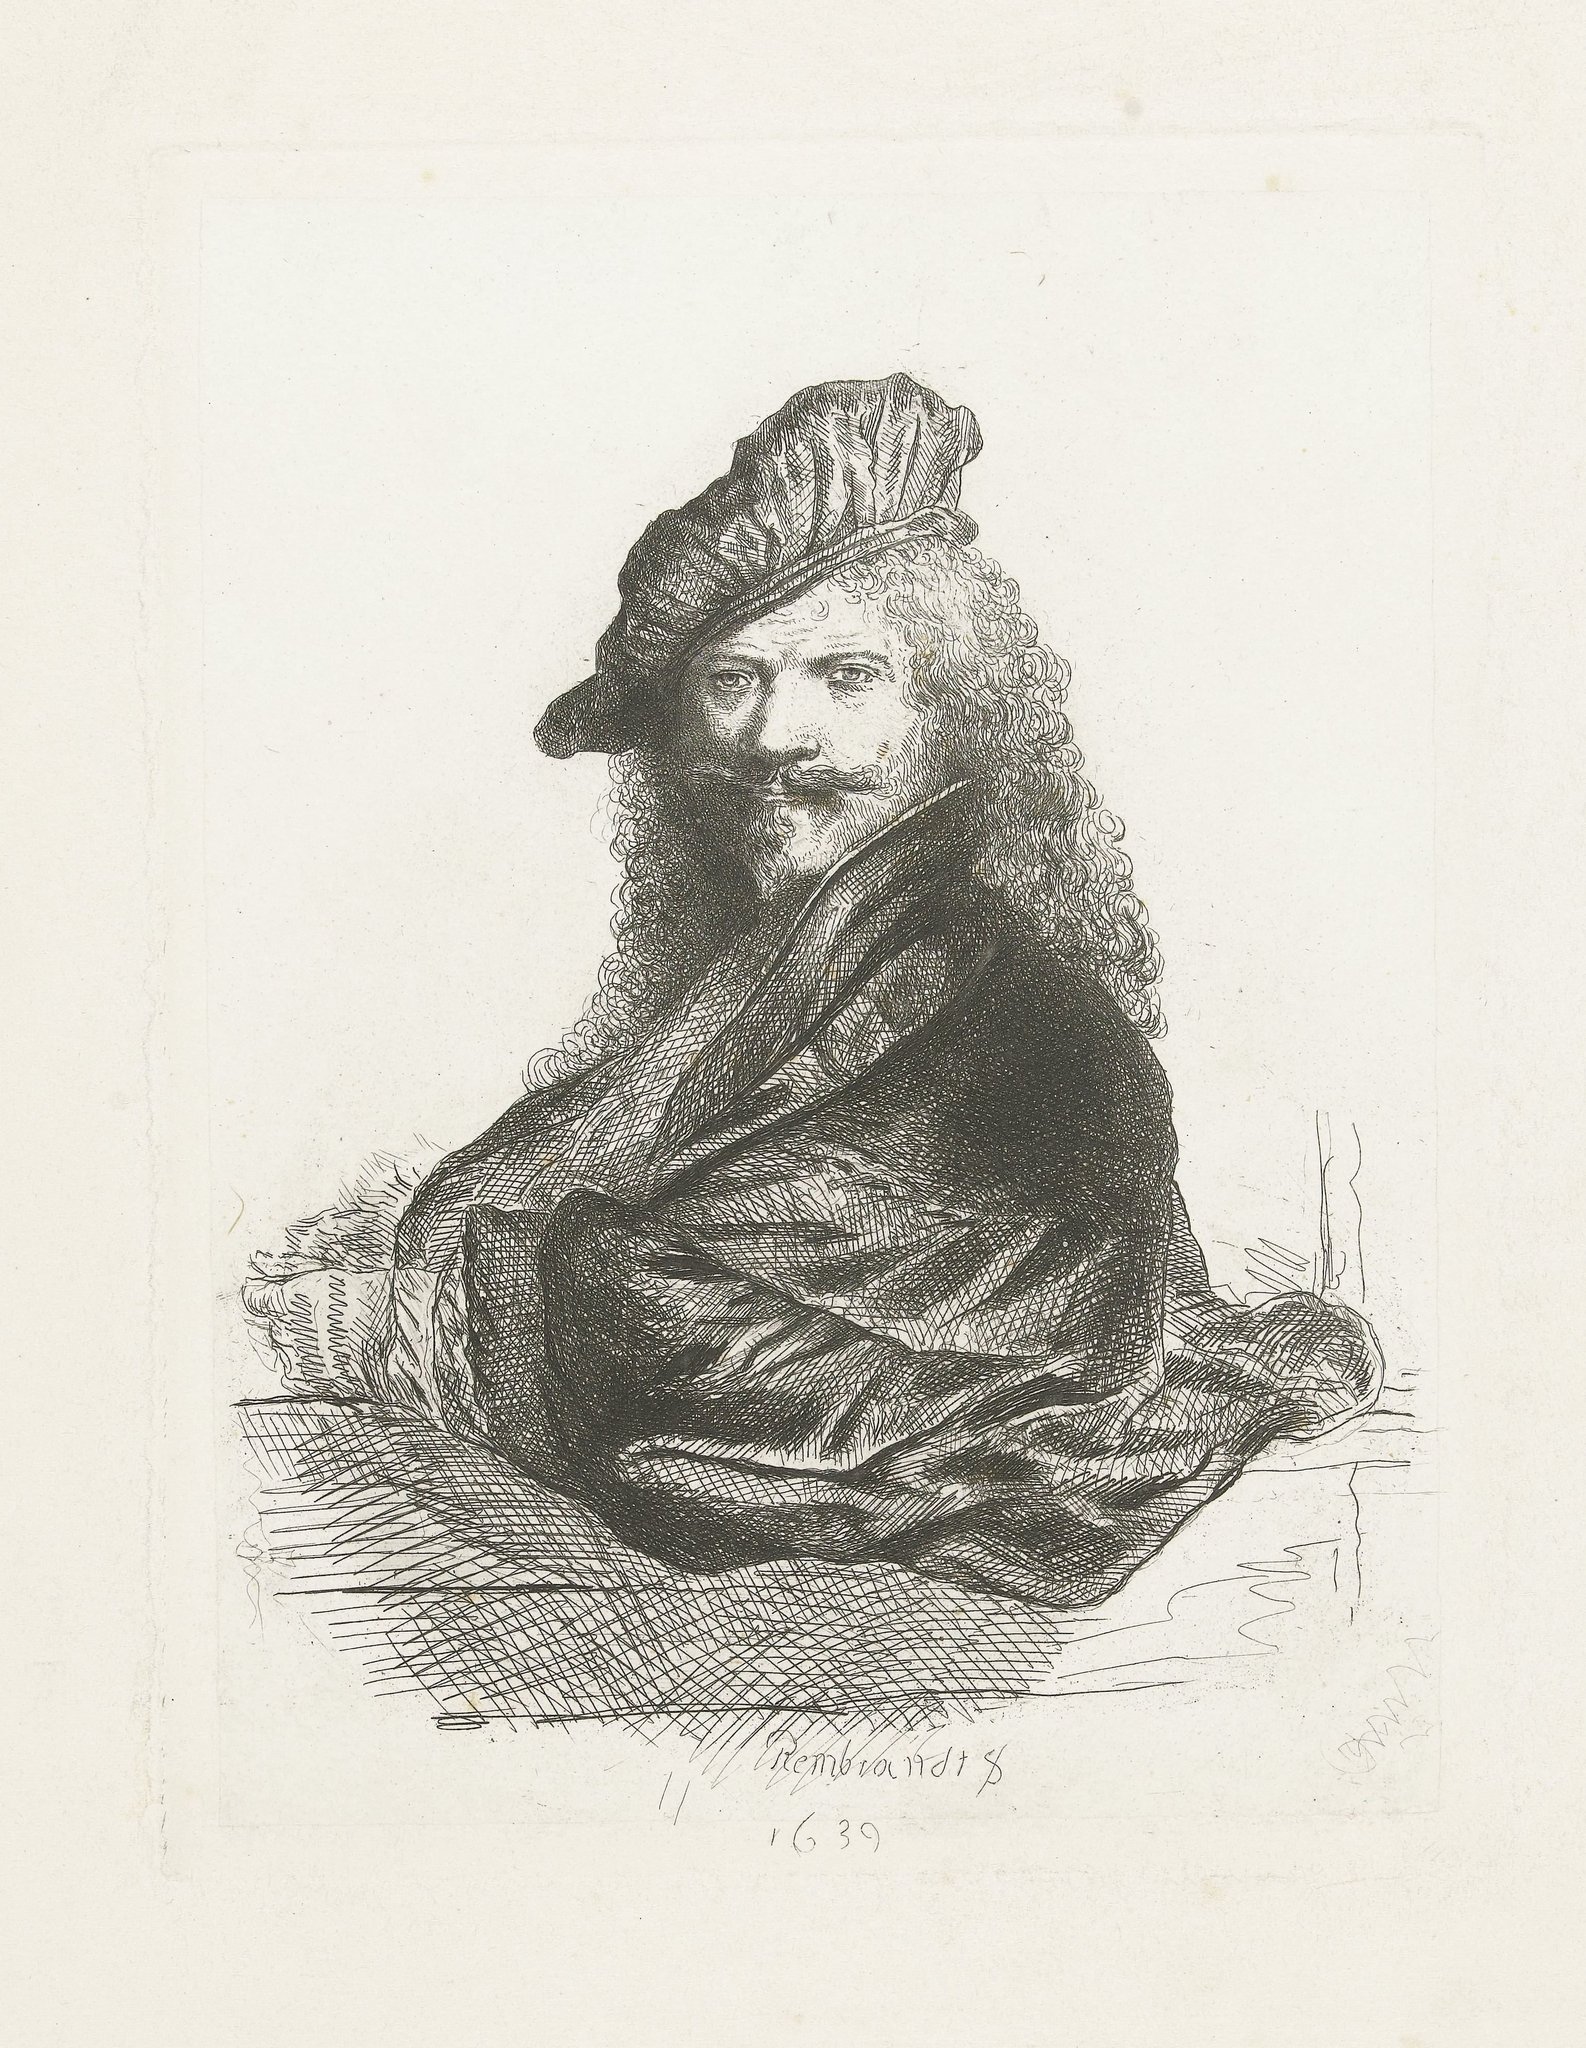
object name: print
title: Portret van Rembrandt Harmensz. van Rijn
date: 1830-1881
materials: paper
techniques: etching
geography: netherlands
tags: leiden, painter, rembrandt van rijn